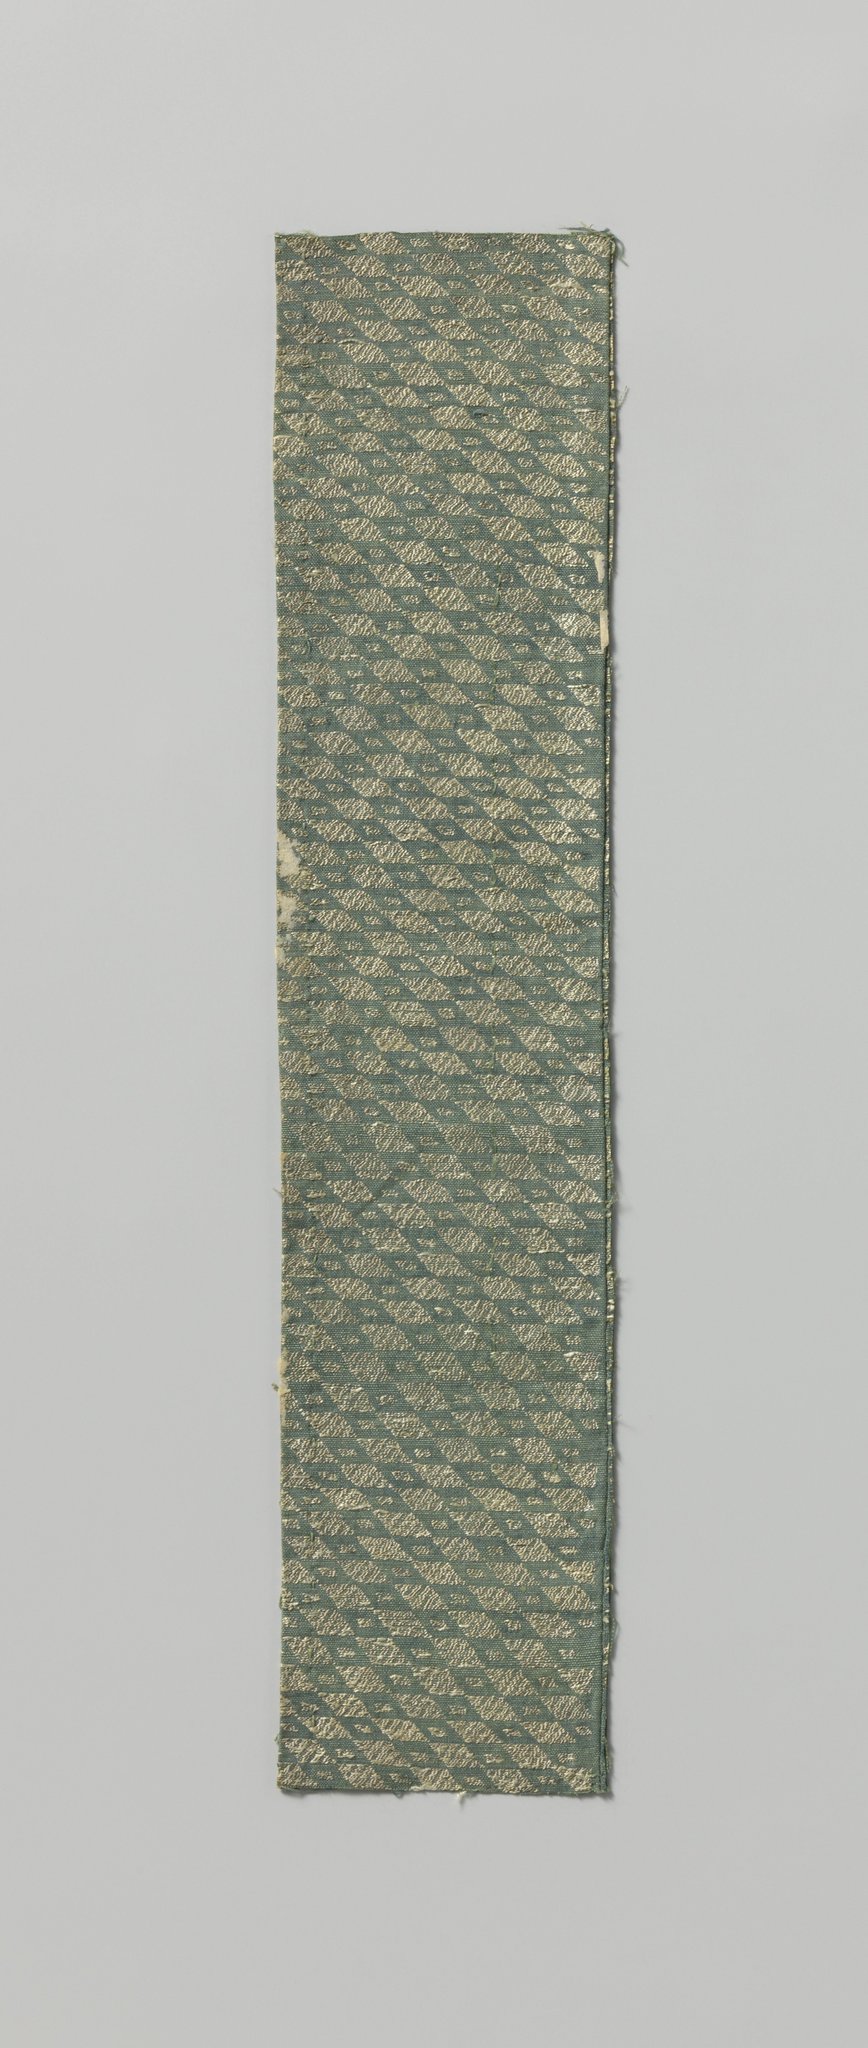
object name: fragment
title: Fragment oosterse textiel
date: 1800-1850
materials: cotton, silk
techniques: brocade, weave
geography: india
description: Een fragment groene weefsel met schuinliggende ruiten van gele zijde met gouddraad. Opmerking: Zelfkant; 6 mm, effenbinding.